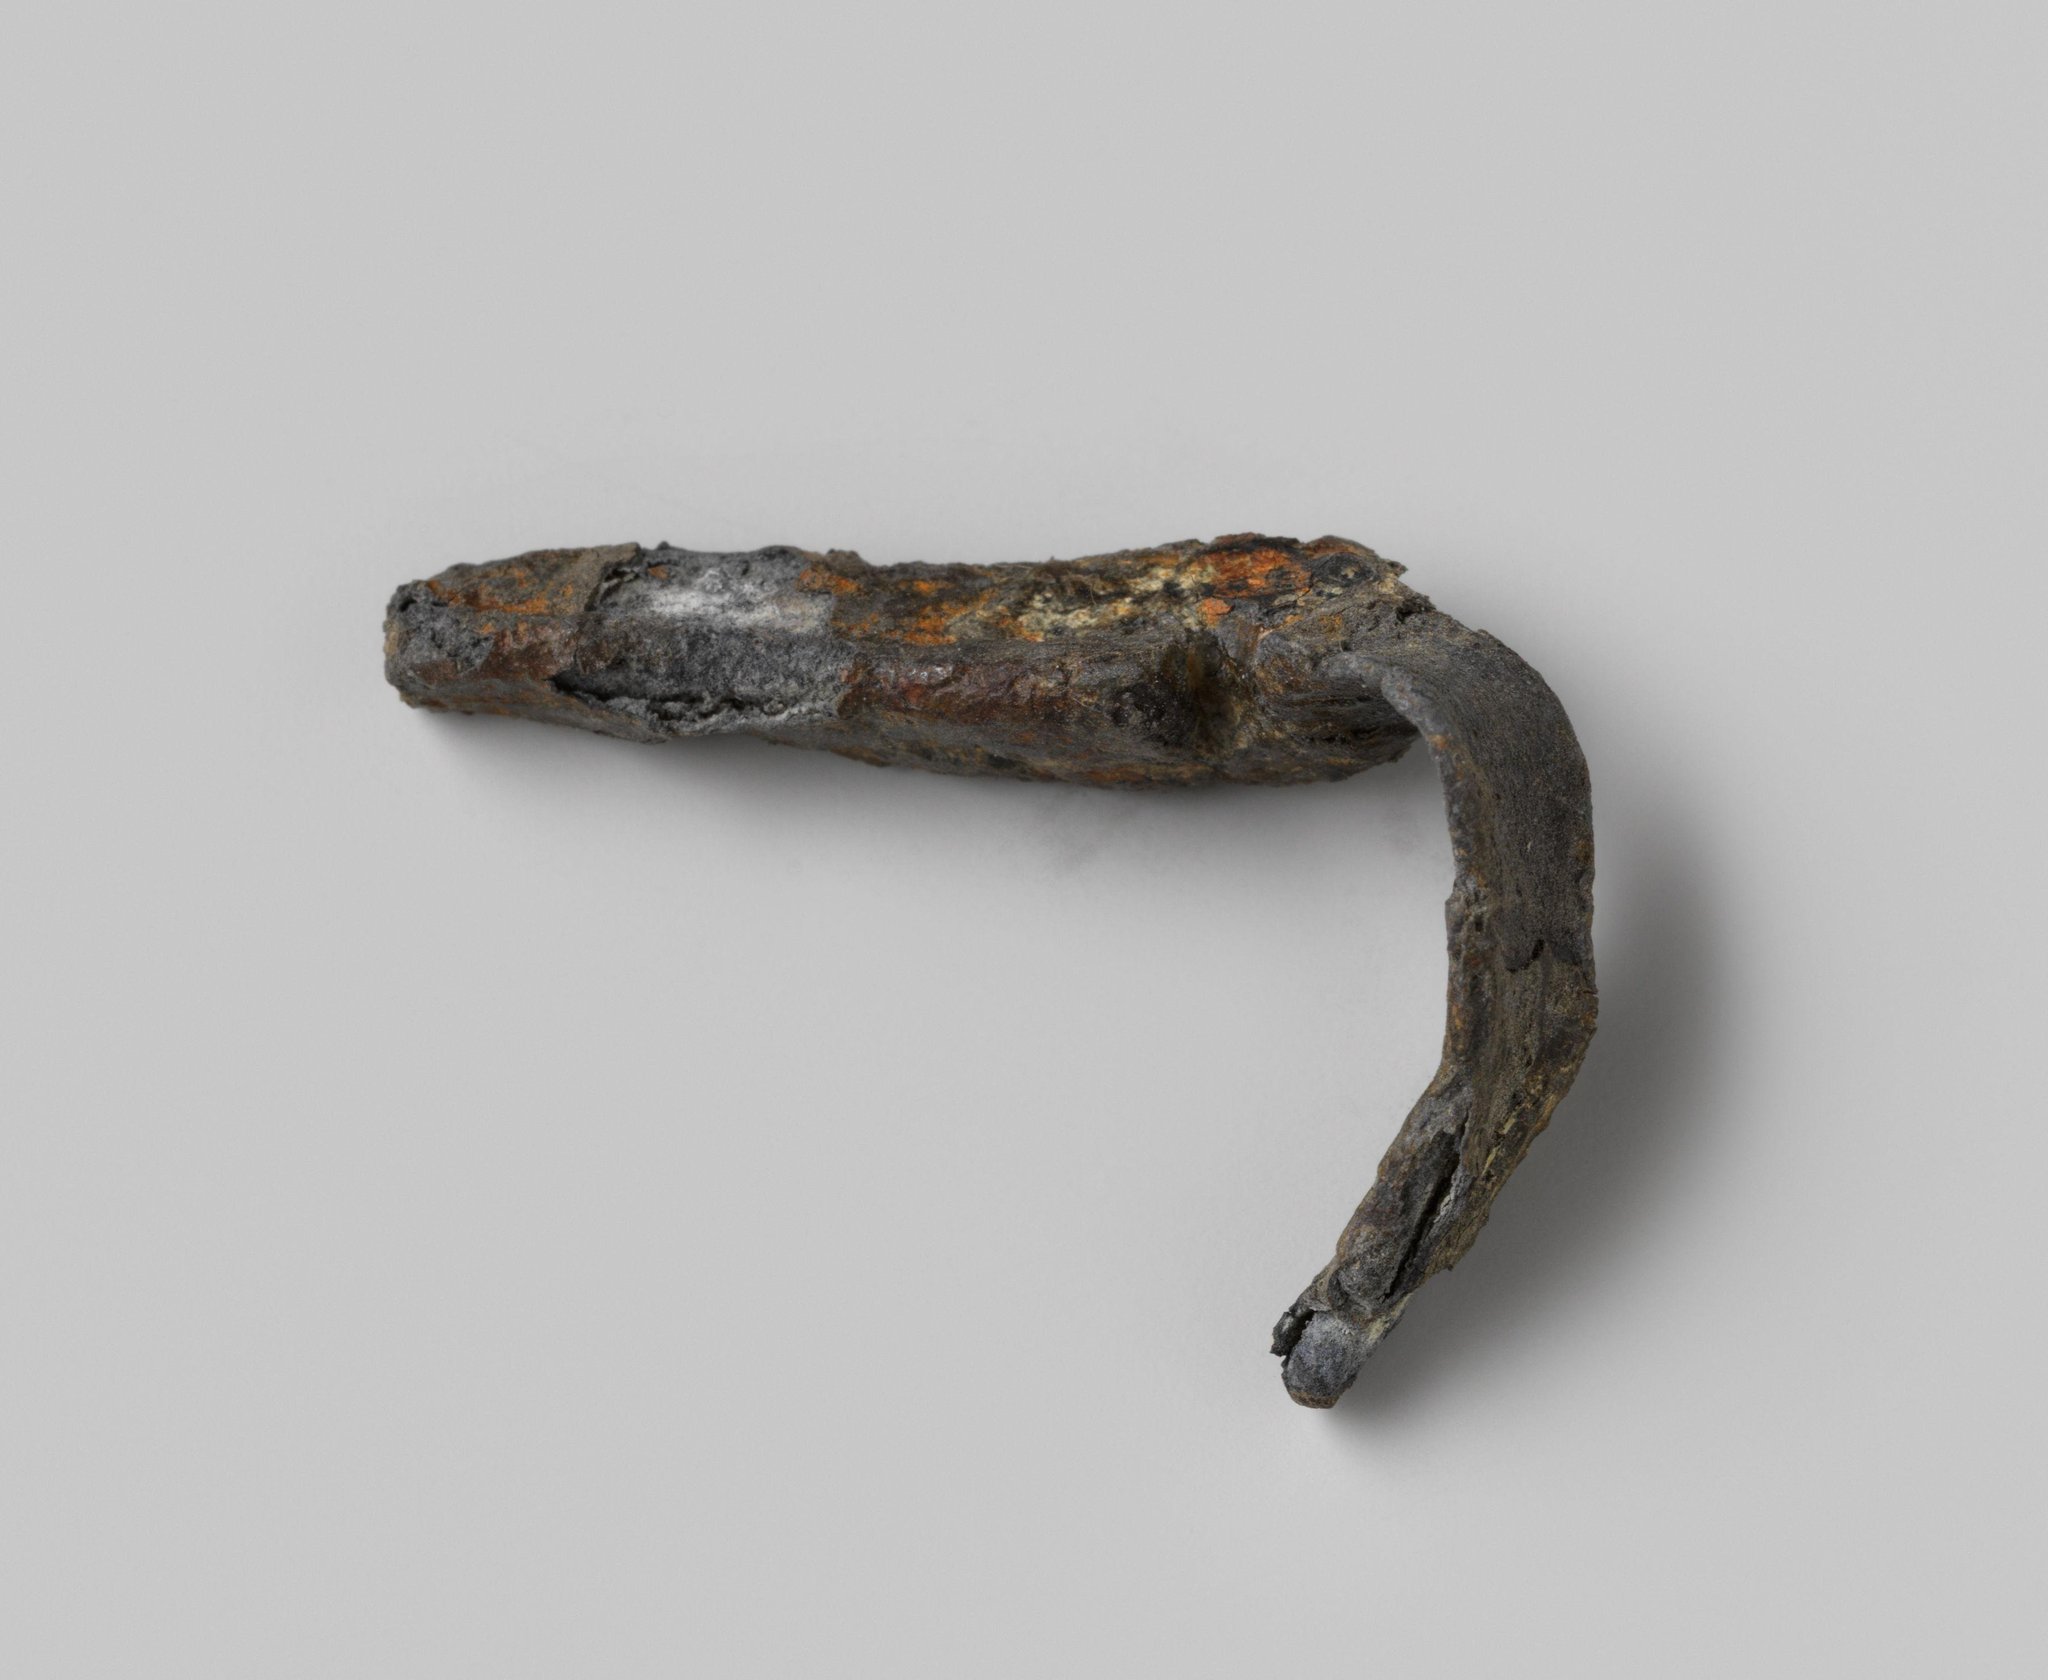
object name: fragment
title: Fragment van tin uit het wrak van de Oost-Indiëvaarder Hollandia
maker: Anonymous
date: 1700-1743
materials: tin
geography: netherlands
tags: verenigde oostindische compagnie, hollandia (schip), annet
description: Varied parts or fragments, unidentified and miscellaneous parts or fragments.